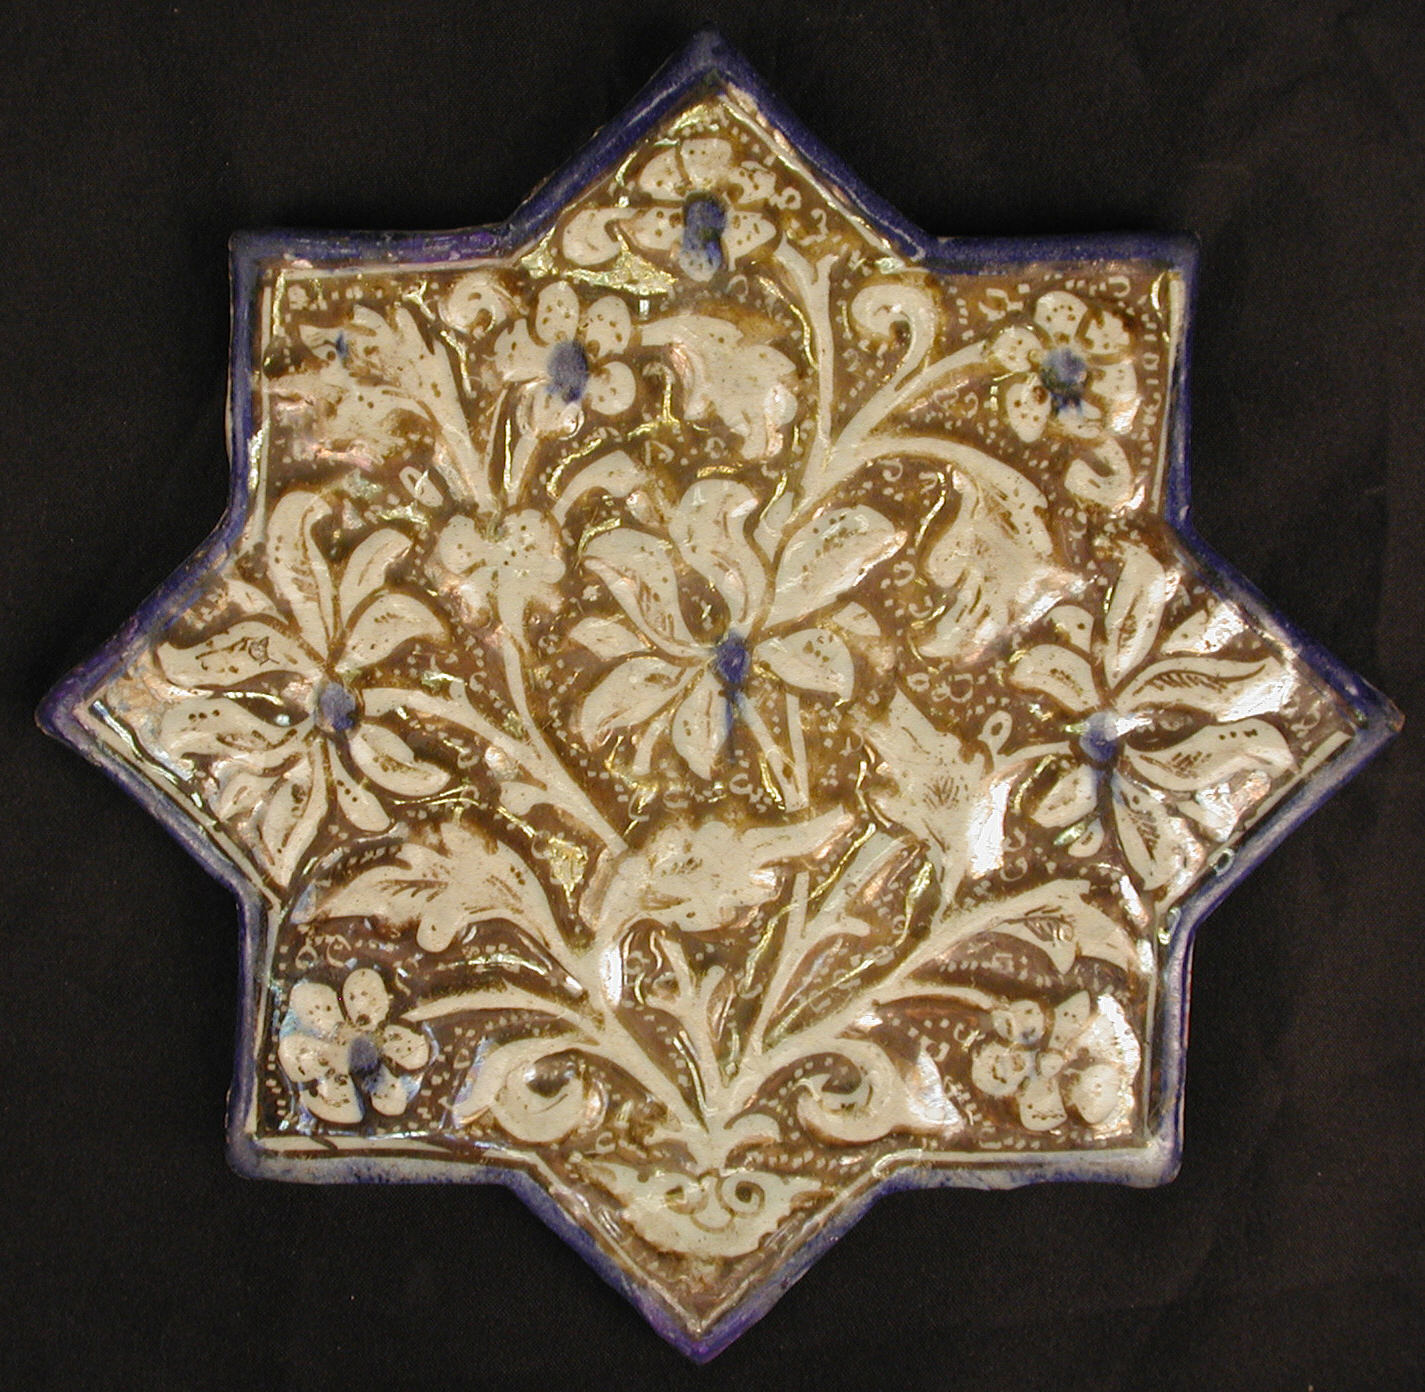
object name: tile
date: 1301-1333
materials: stonepaste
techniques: glazing, luster painting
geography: iran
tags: flowers